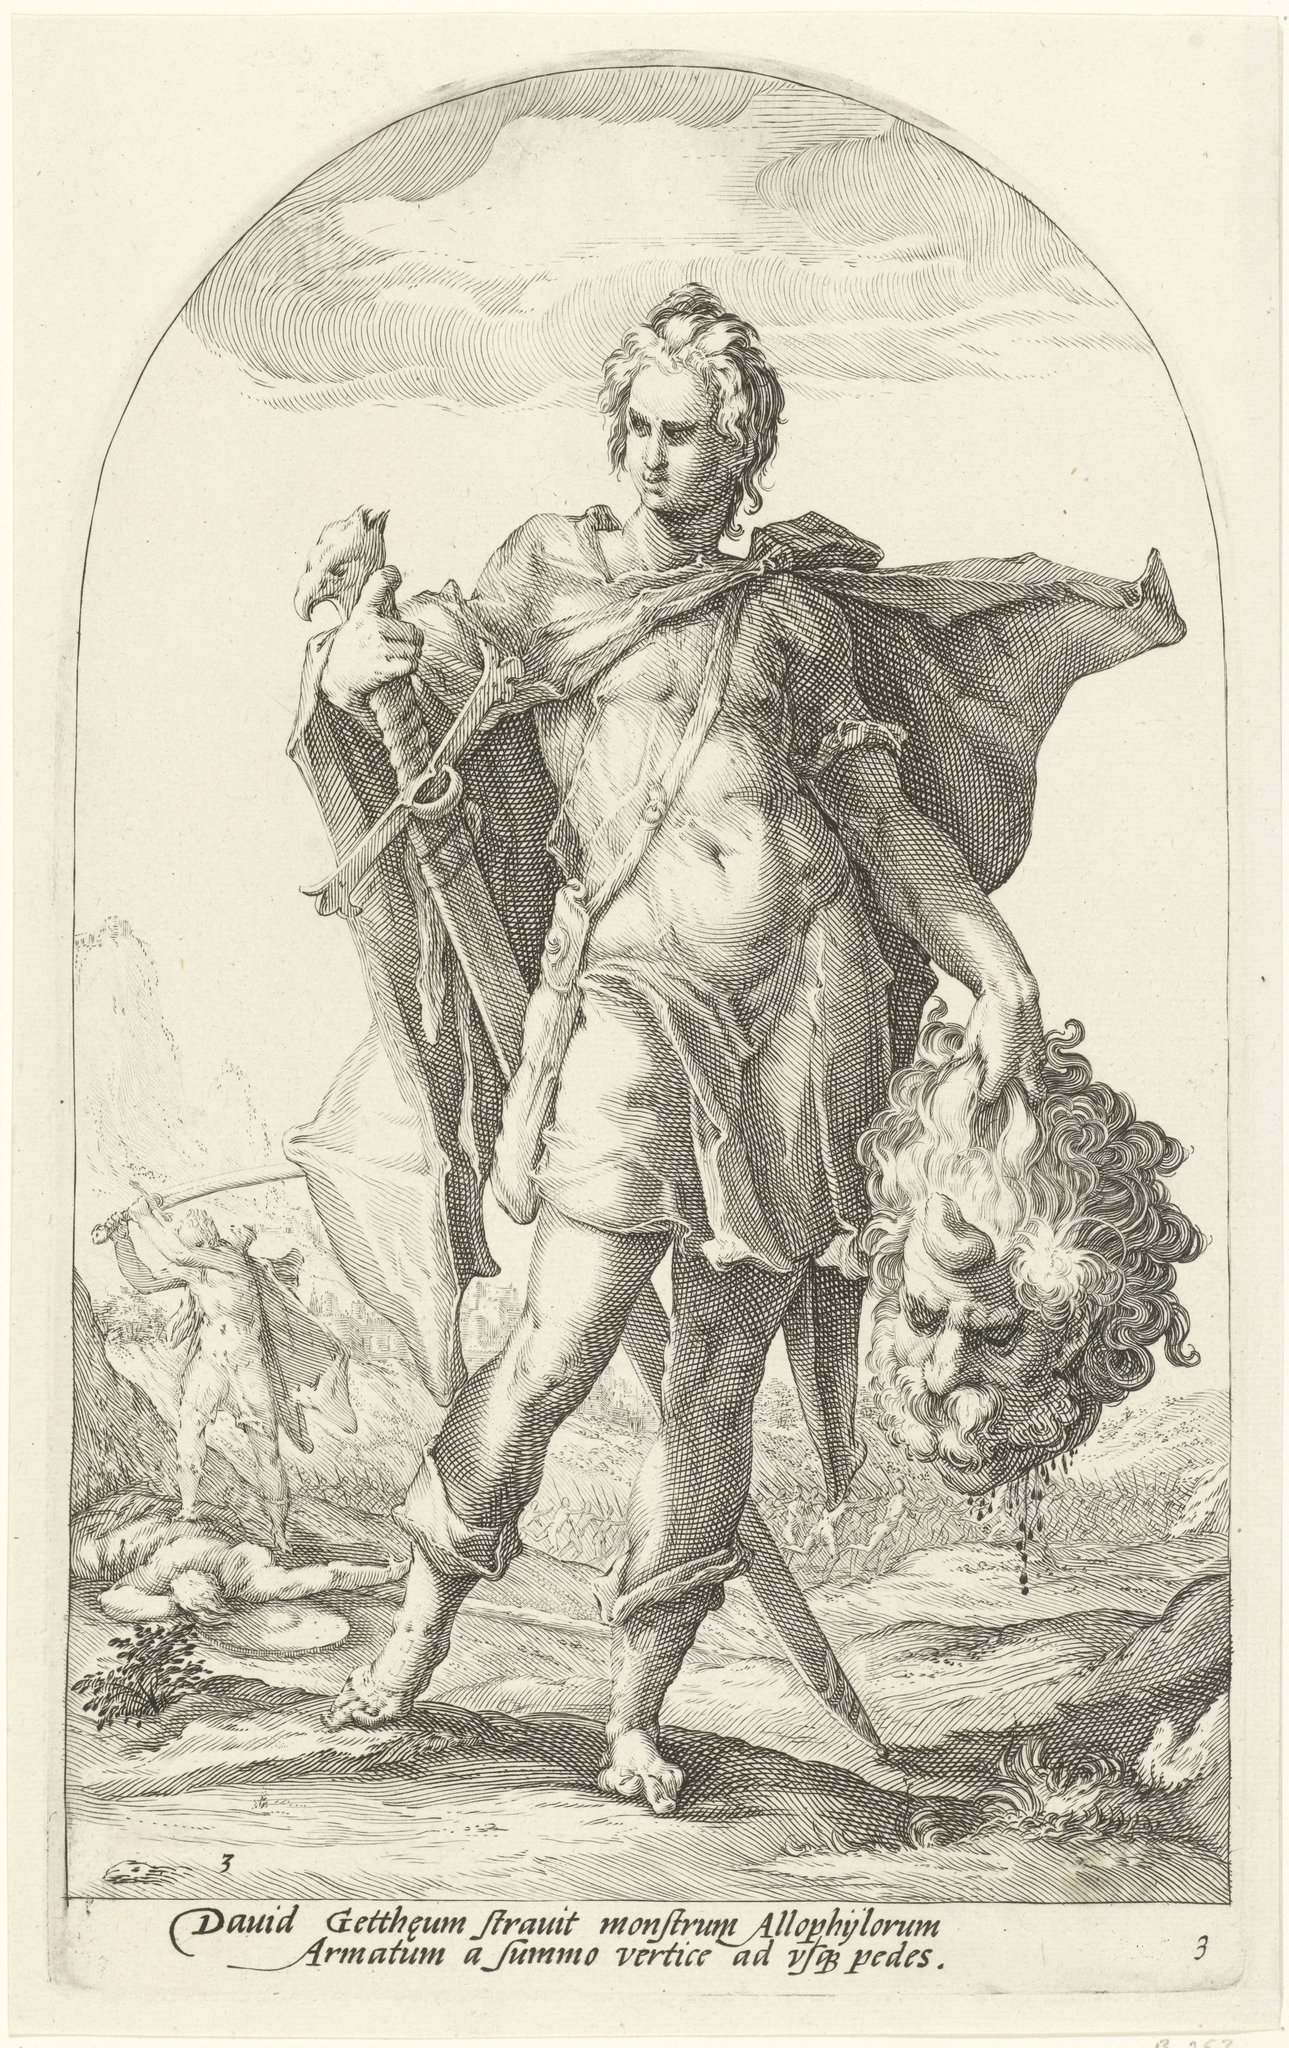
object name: print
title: David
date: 1585-1589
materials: paper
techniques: engraving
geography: amsterdam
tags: david with goliath's head, david (not in biblical context); possible attributes: crown, harp, david beheads goliath with a sword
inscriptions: collector's mark: Lugt 2165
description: David met een zwaard en het hoofd van Goliath. Op de achtergrond de scène waarin hij Goliath het hoofd afhakt.